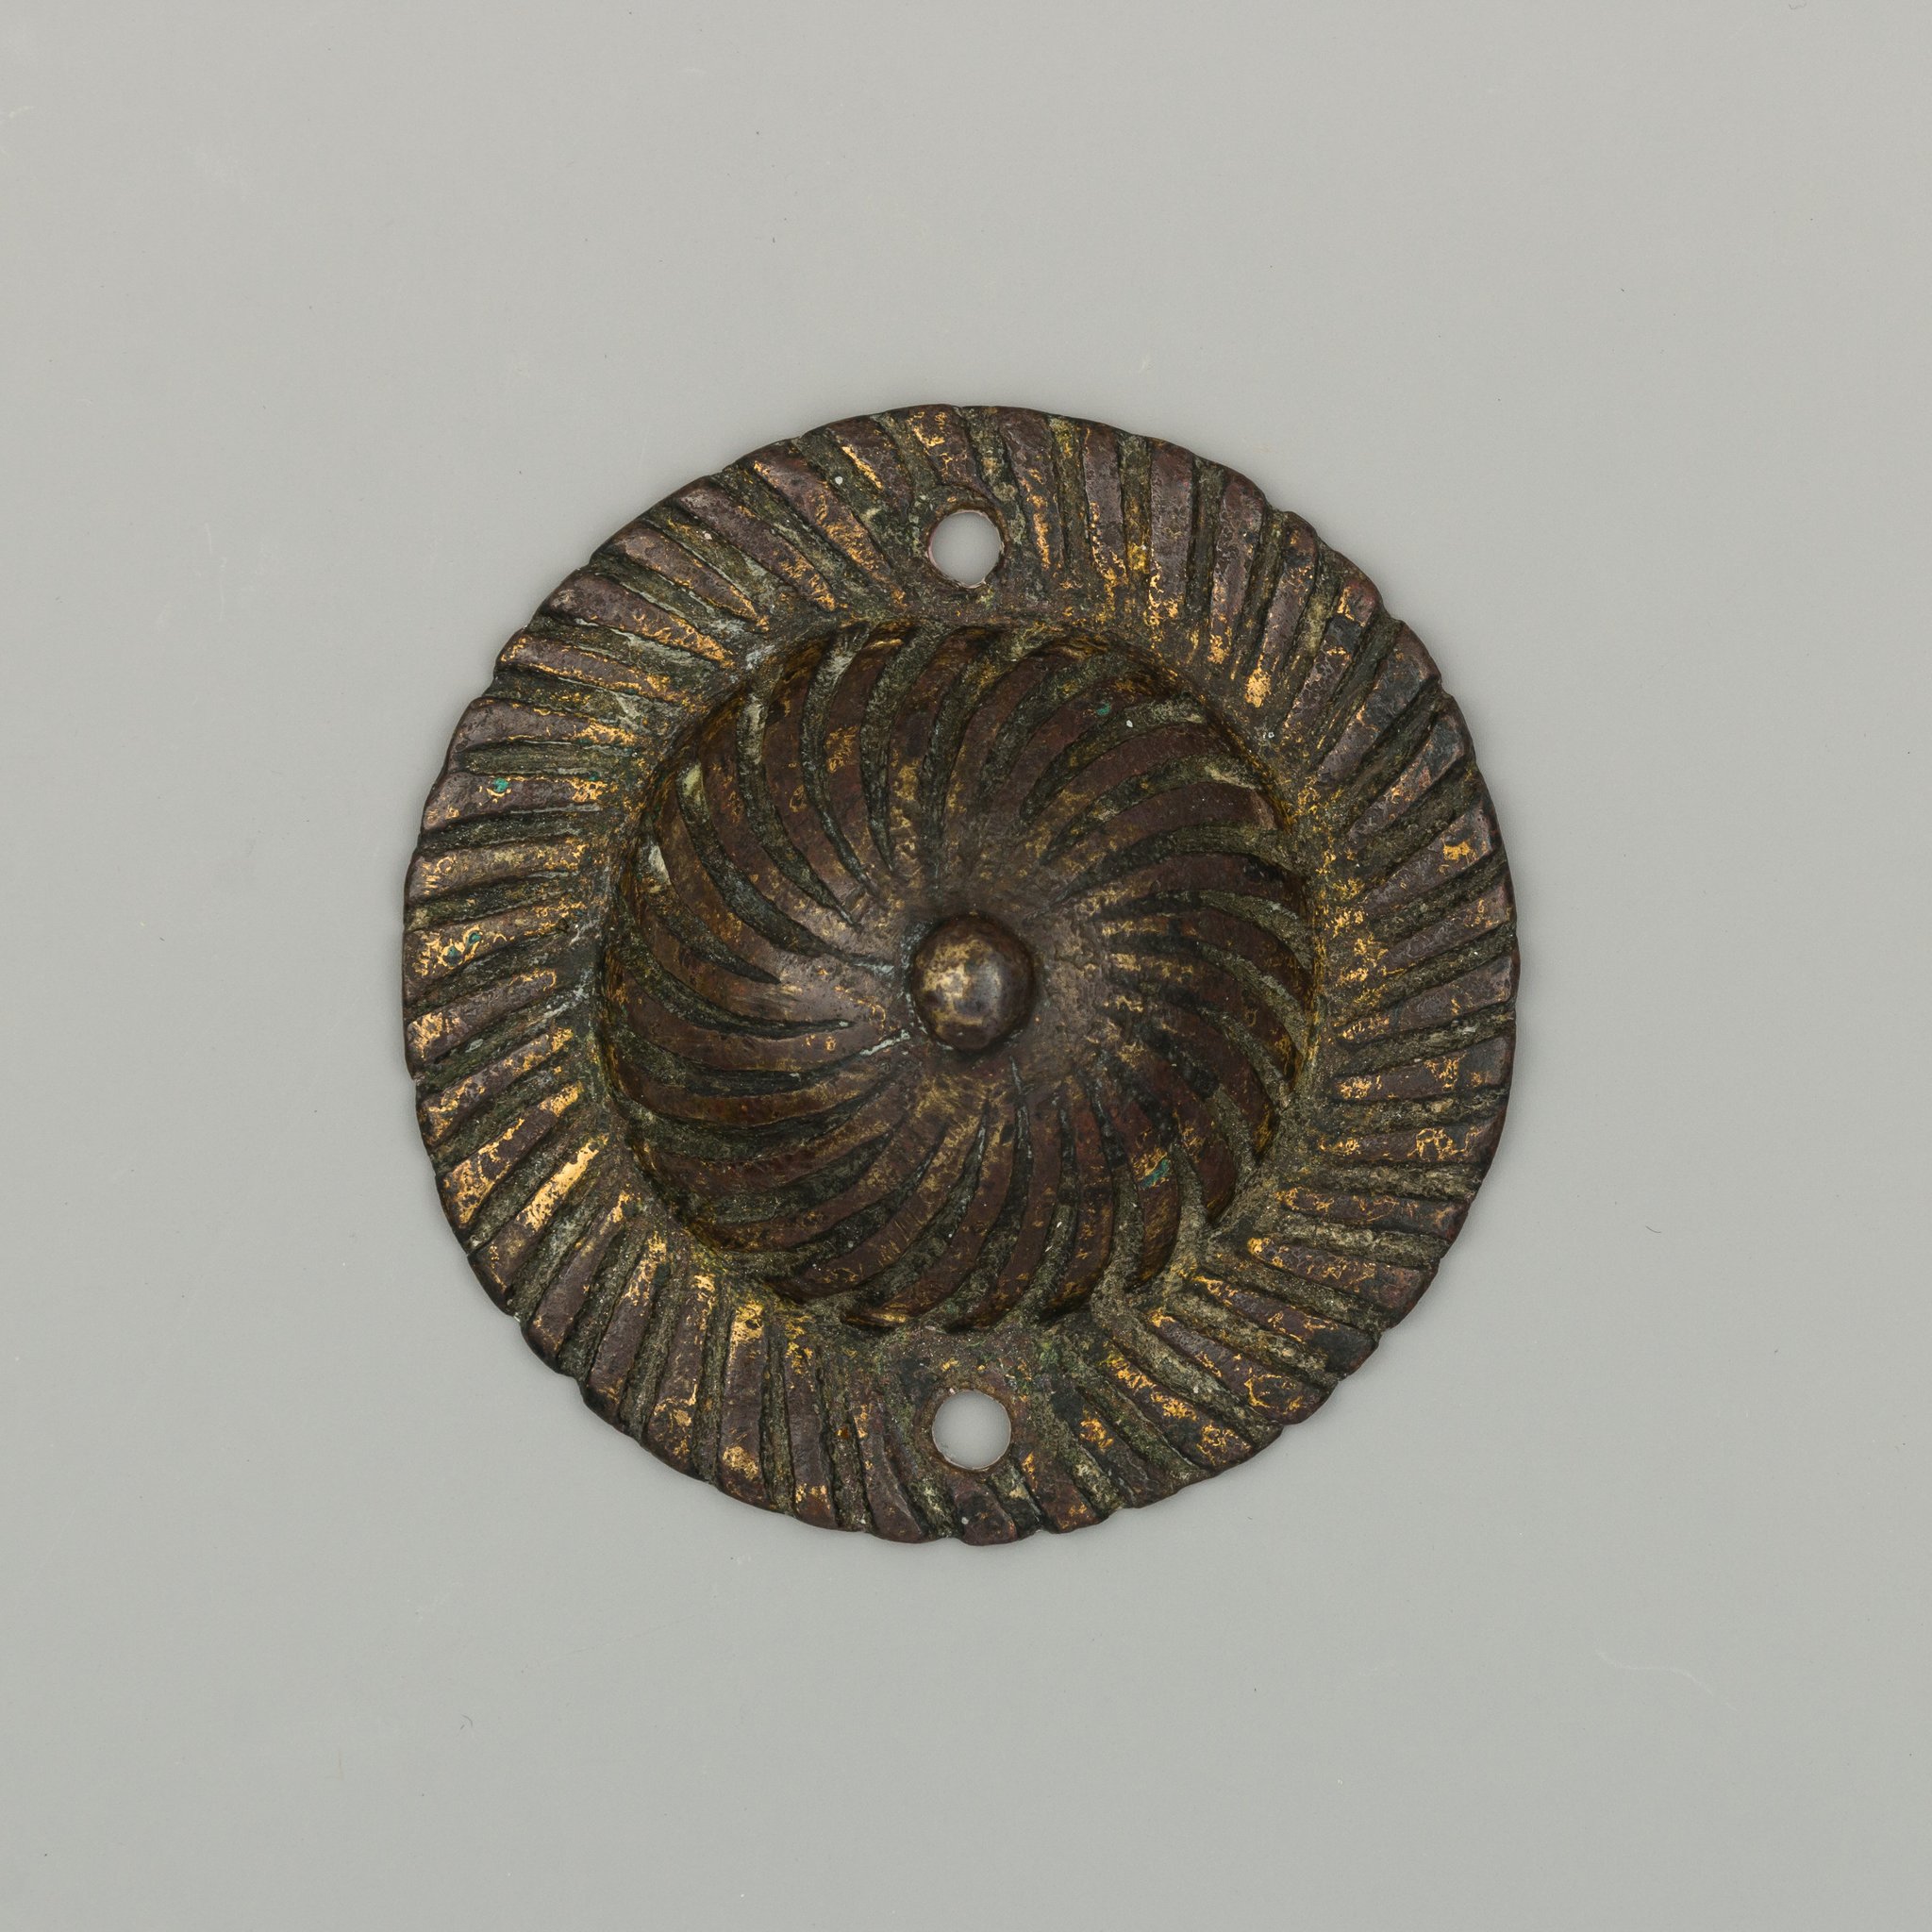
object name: bit bos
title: Bit Boss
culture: french or italian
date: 1567-1700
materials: copper alloy, gold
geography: france